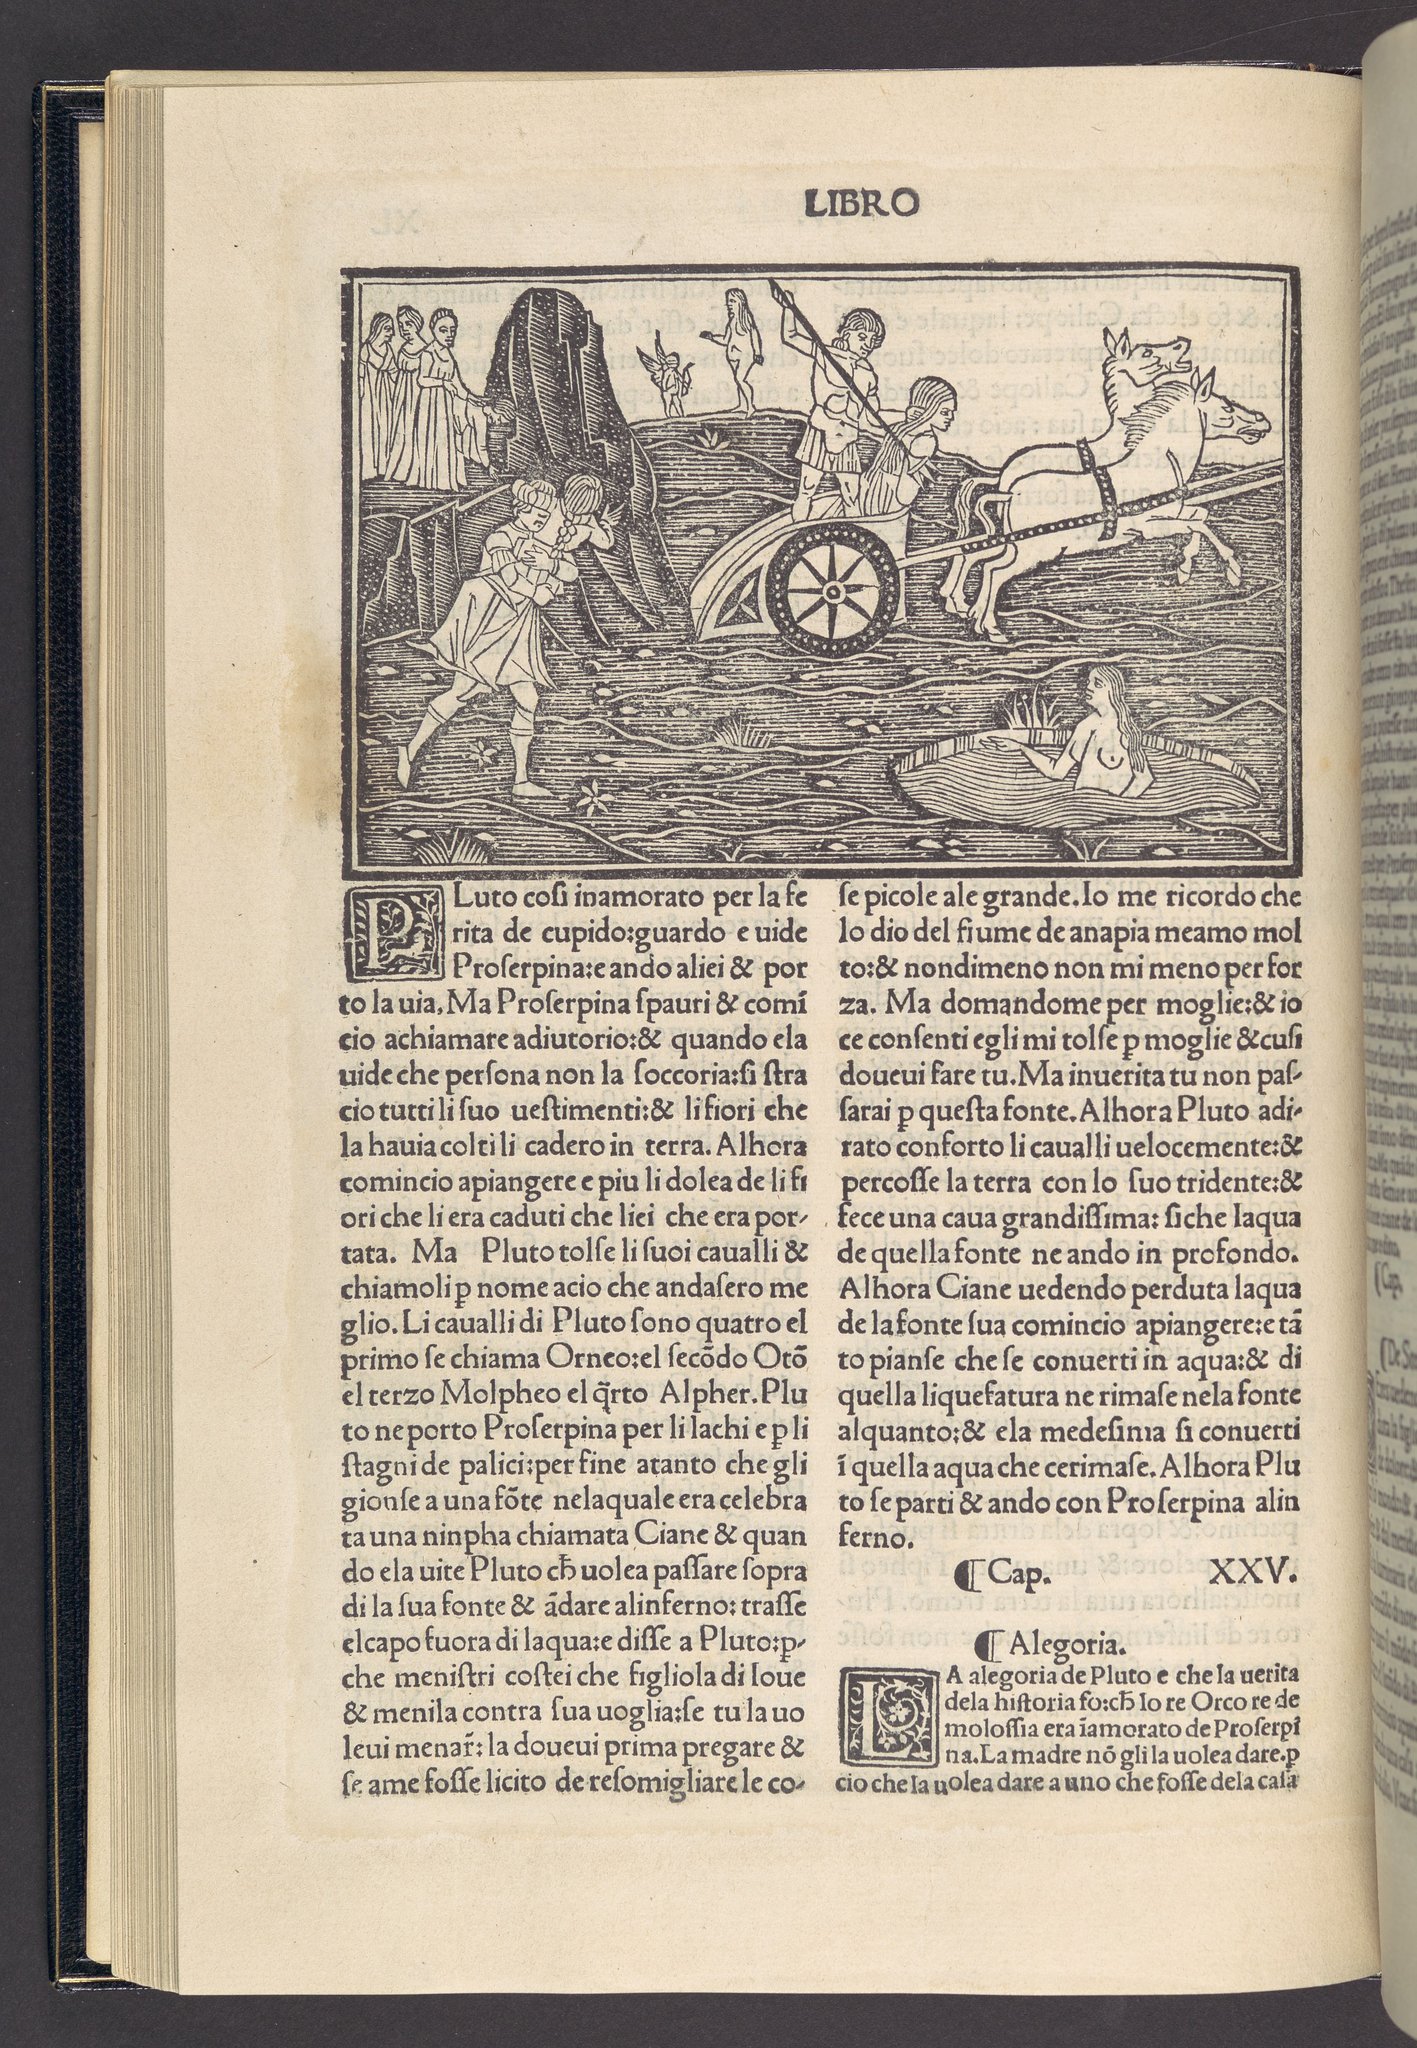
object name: book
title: Methamorphoseos vulgare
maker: ovid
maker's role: author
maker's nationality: roman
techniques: printing, woodcut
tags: mars,venus,vulcan,horses,chariots